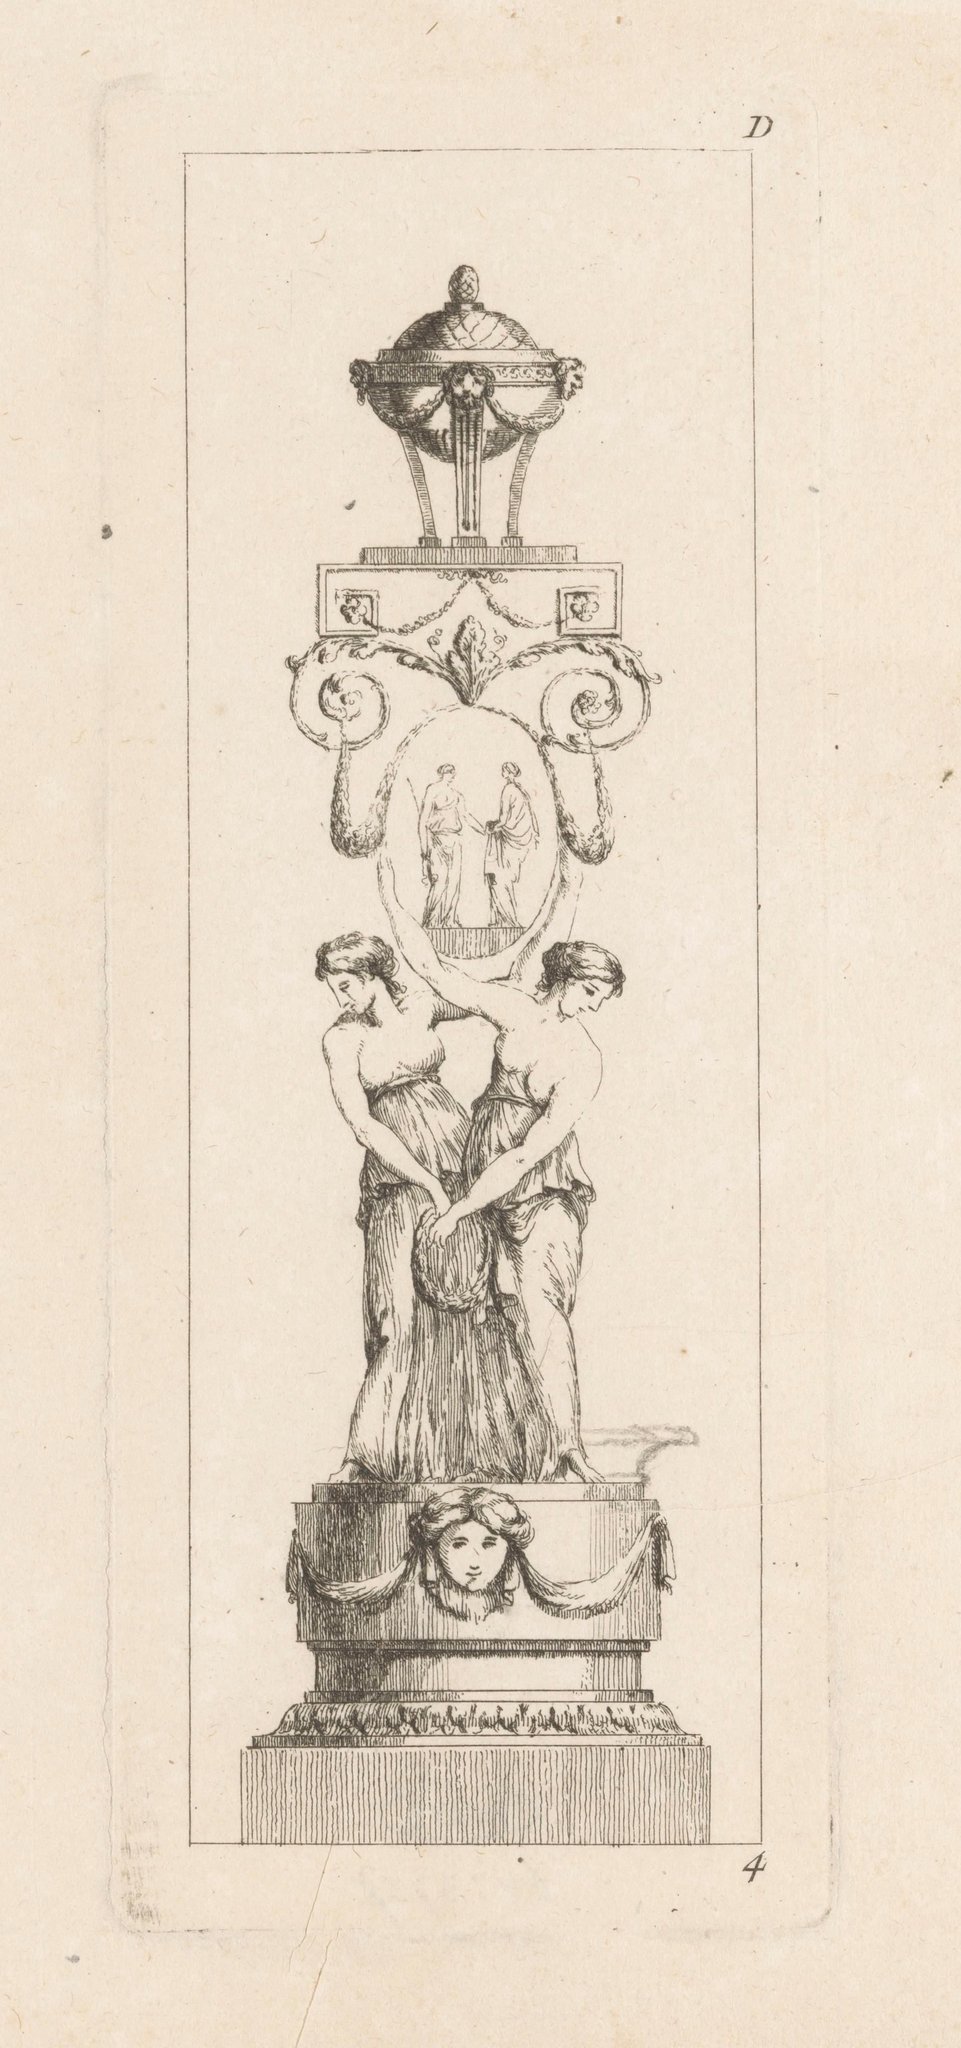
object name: ornament print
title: D 4e Suite d'Arabesques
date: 1752-1782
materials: paper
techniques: etching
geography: paris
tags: ornament ~ arabesque, ornament ~ medallion, vase ~ ornament, standing figure - aa - female human figure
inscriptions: collector's mark: Lugt 2228, collector's mark: Lugt 2760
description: Twee staande vrouwen ondersteunen een medaillon met twee figuren, daarboven arabesken en een vaas.